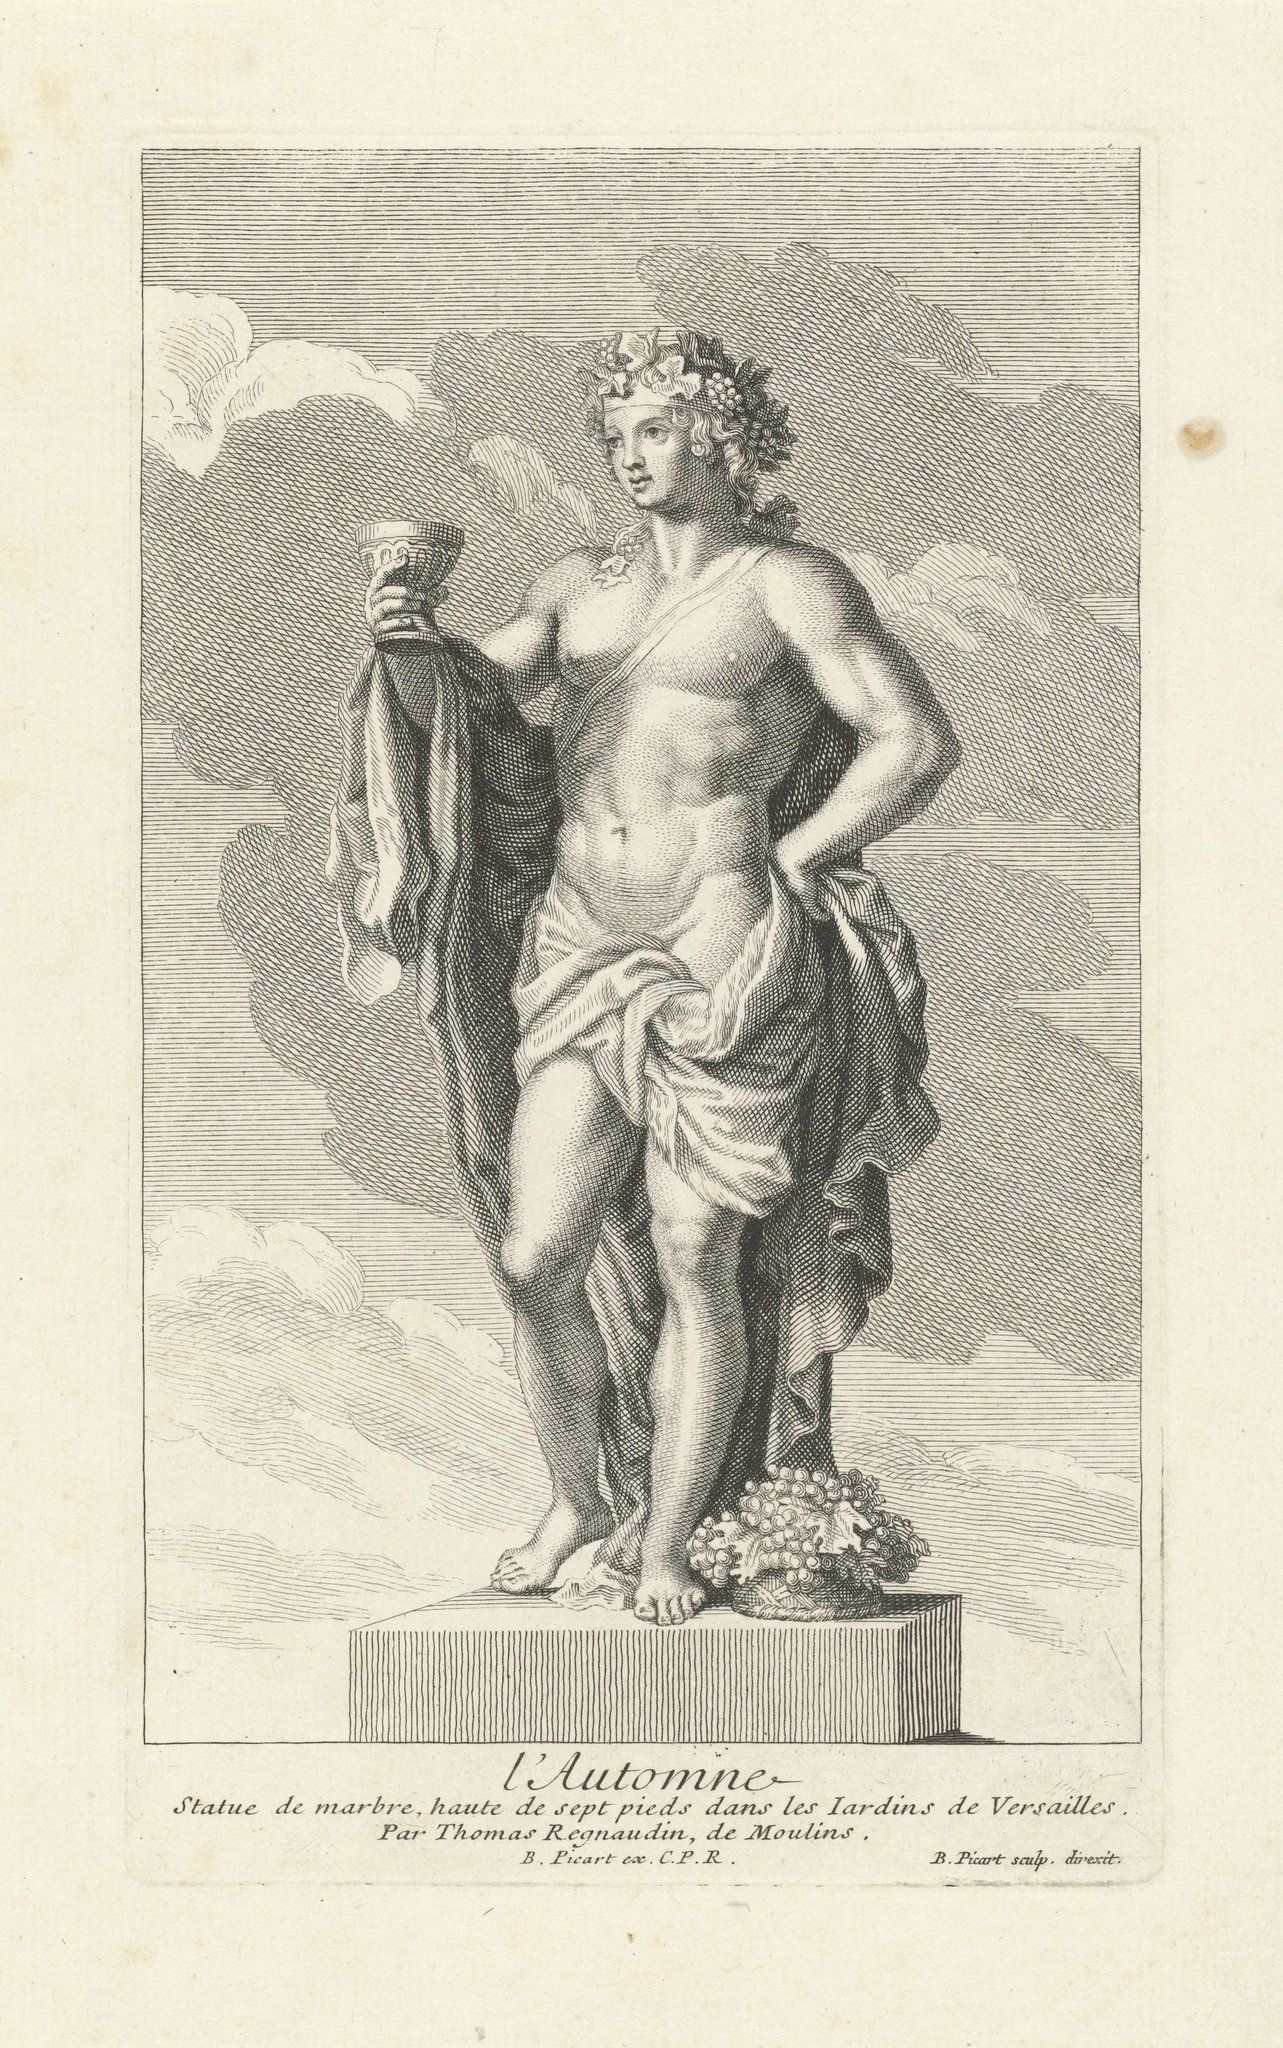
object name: print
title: Standbeelden uit de tuinen van Versailles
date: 1709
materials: paper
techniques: engraving, etching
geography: paris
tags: piece of sculpture, reproduction of a piece of sculpture, autumn, fall, 'autumnus'; 'autunno' (ripa)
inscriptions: collector's mark: Lugt 240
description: Standbeeld in de tuinen van Versailles. De mannelijke personificatie van Herfst, een drinkbeker in de hand. Aan zijn voeten een tros druiven. In de marge een onderschrift in het Frans.